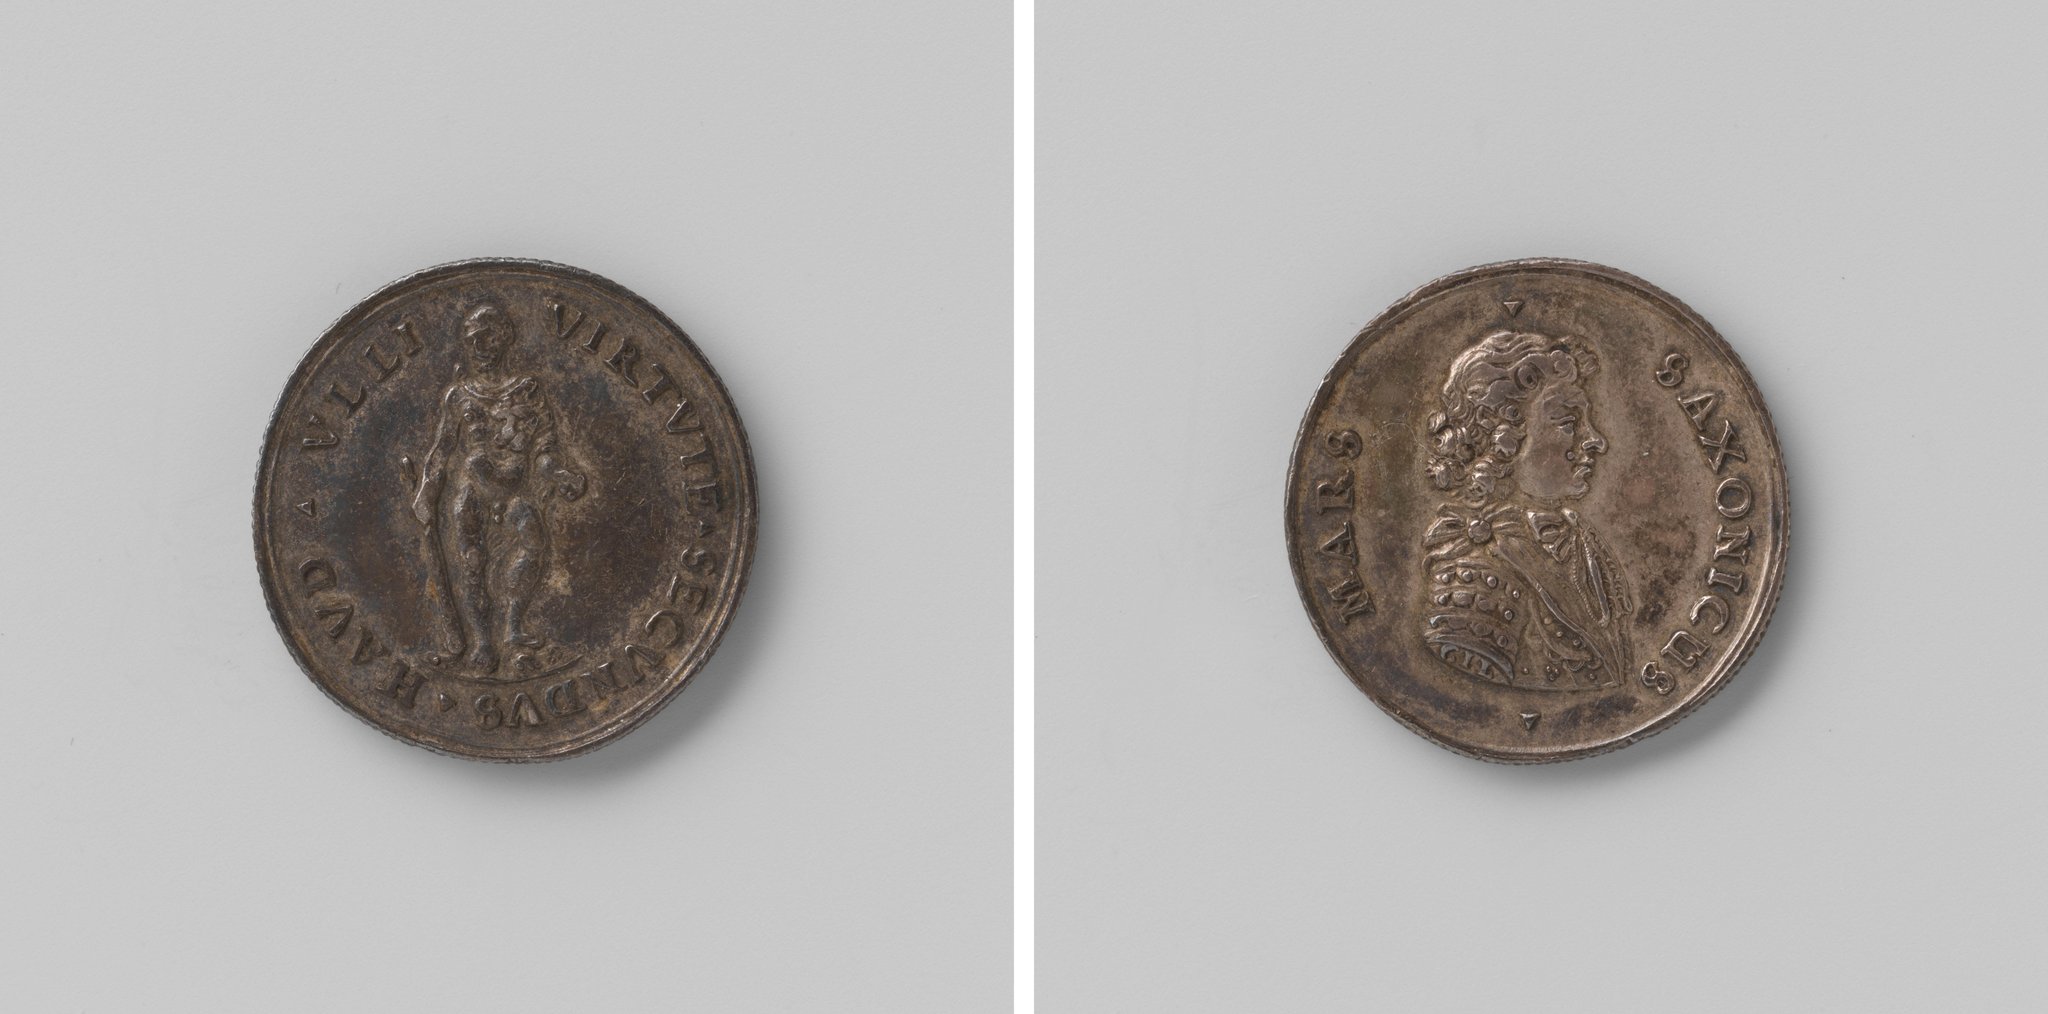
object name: strooipenning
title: Johan Georg III, hertog van Saksen trekt over de Rijn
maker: christoph jakob leherr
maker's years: 1647-1707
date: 1691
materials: silver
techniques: striking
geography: augsburg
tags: tübingen, keurvorst, keurvorst van saksen johan georg iii, rijn, johan georg iii steekt rijn over, negenjarige oorlog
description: Zilveren penning. Voorzijde: borststuk man binnen omschrift. Keerzijde: Hercules met knots binnen omschrift.